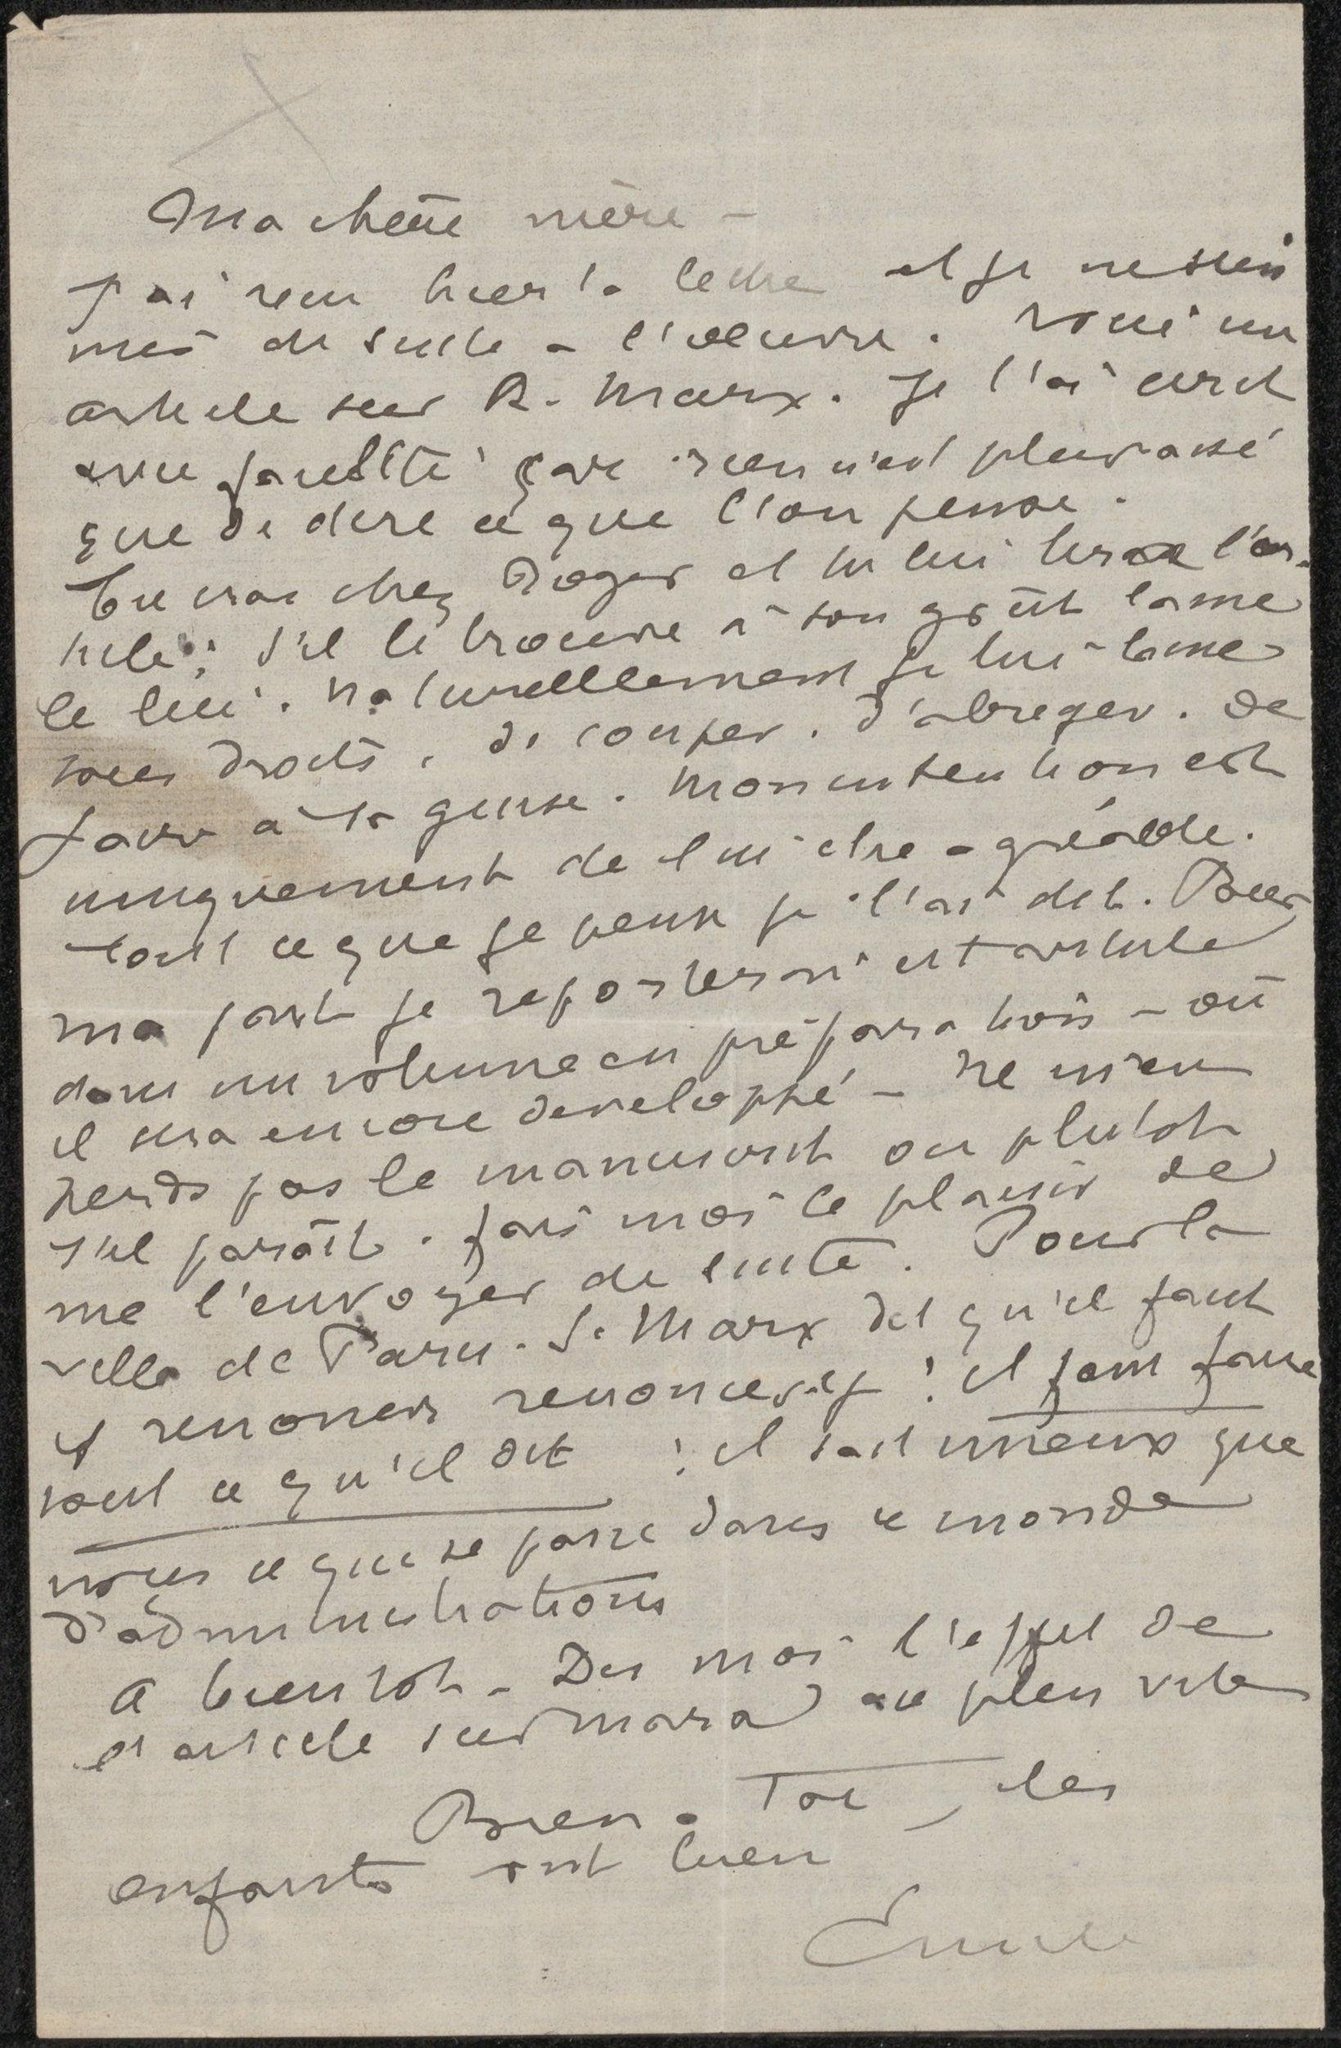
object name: letter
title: Brief aan Héloïse Bernard-Bodin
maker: émile bernard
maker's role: print maker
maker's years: 1868-1941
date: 1878-1941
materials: ink, paper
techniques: pen, writing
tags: héloïse bernard-bodin